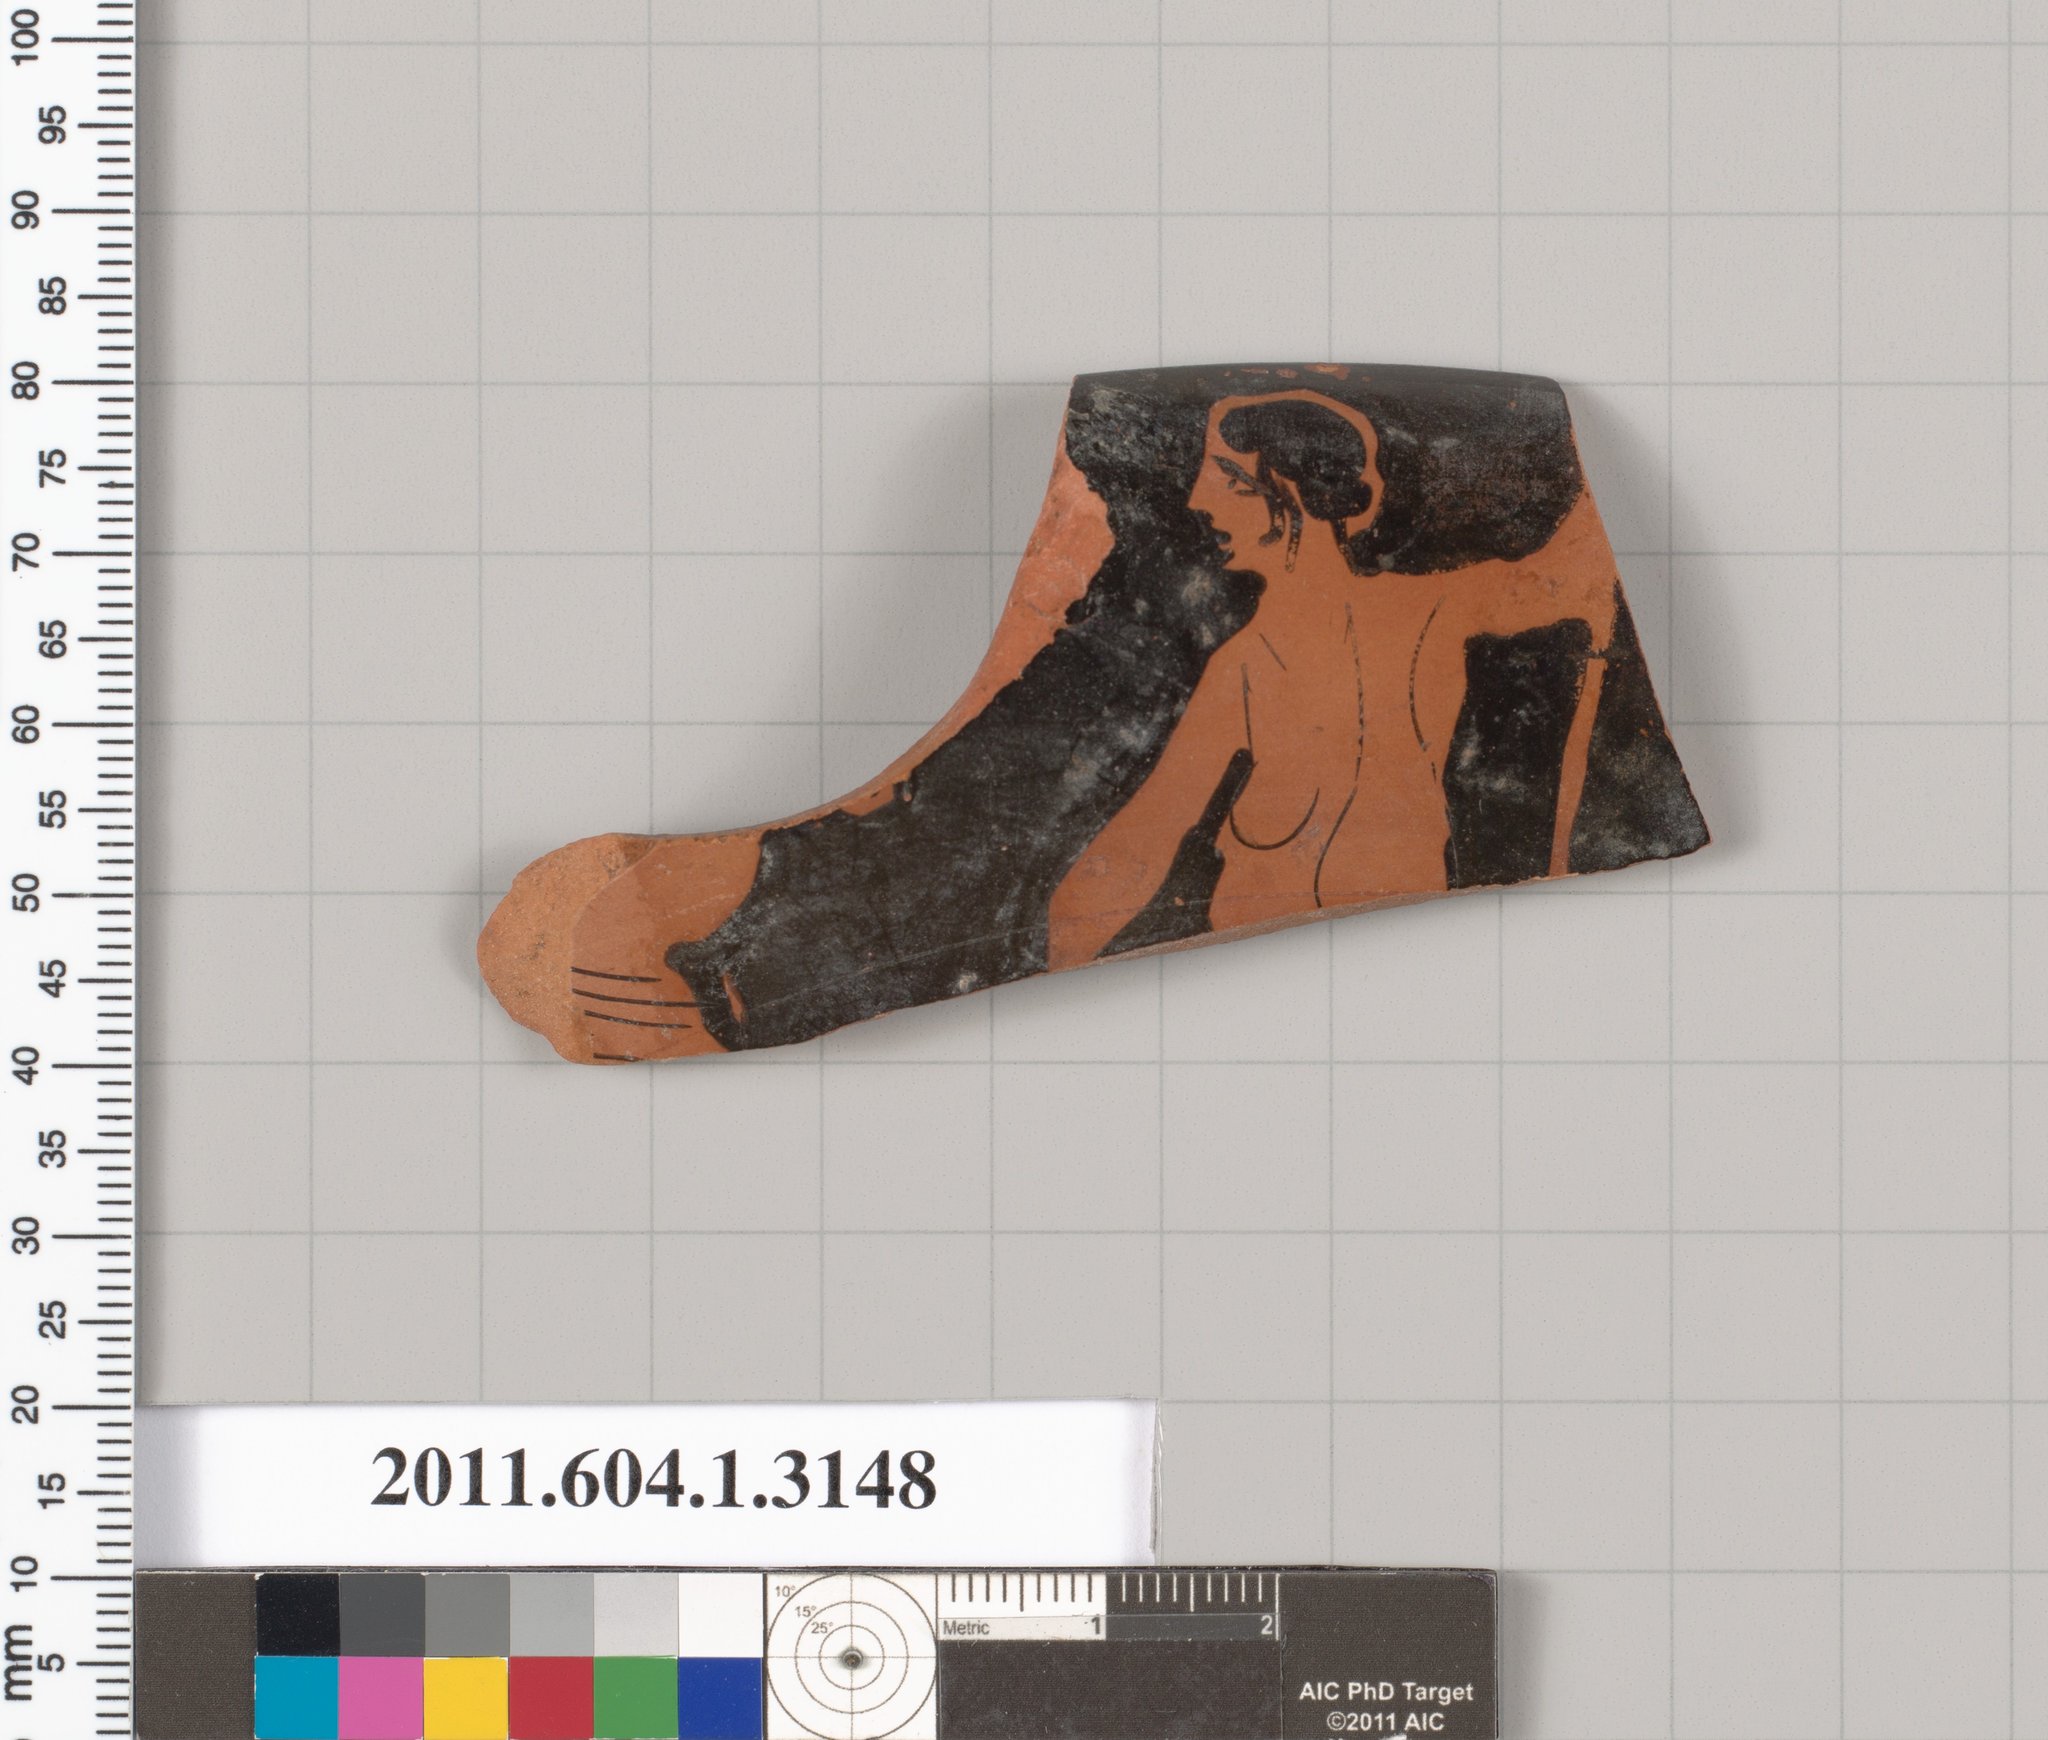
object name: kylix fragment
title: Terracotta rim fragment of a kylix (drinking cup)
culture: greek, attic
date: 450-426 BCE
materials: terracotta